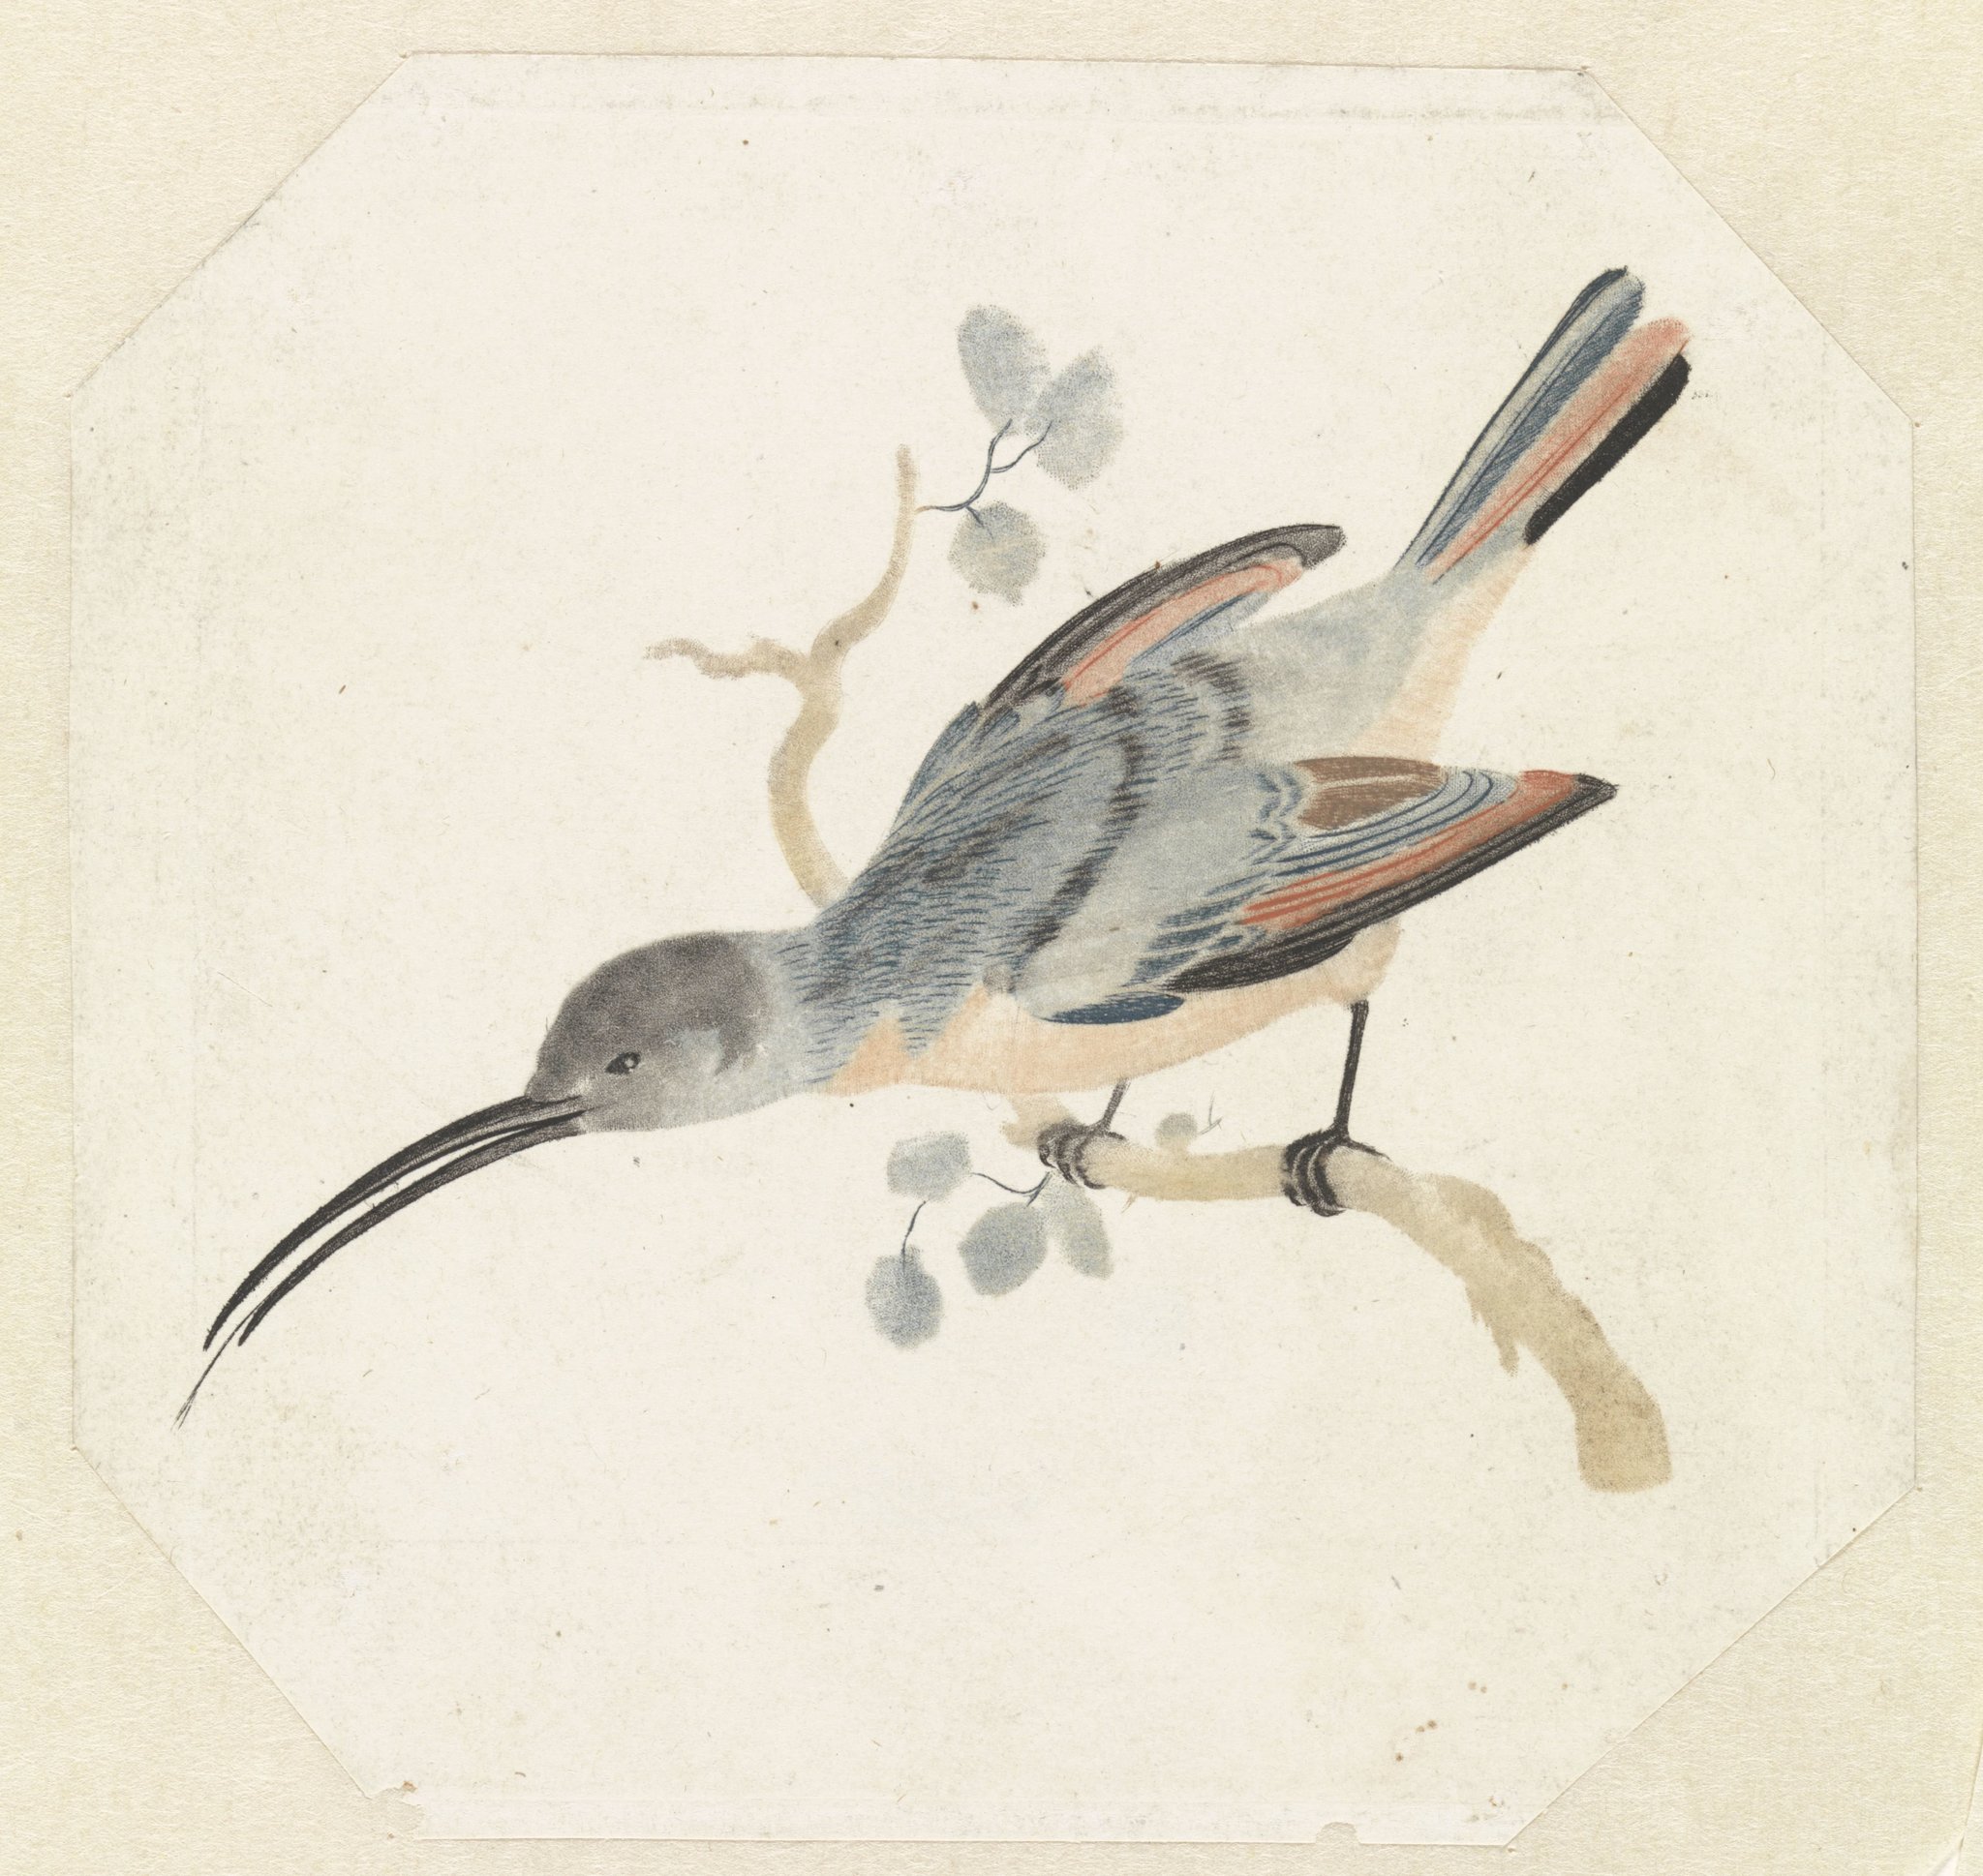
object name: print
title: Kolibrie op een tak naar links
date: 1688-1698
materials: paper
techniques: printing, engraving, lithography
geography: netherlands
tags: other birds (with name)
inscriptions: collector's mark: Lugt 2228, collector's mark: Lugt 2760